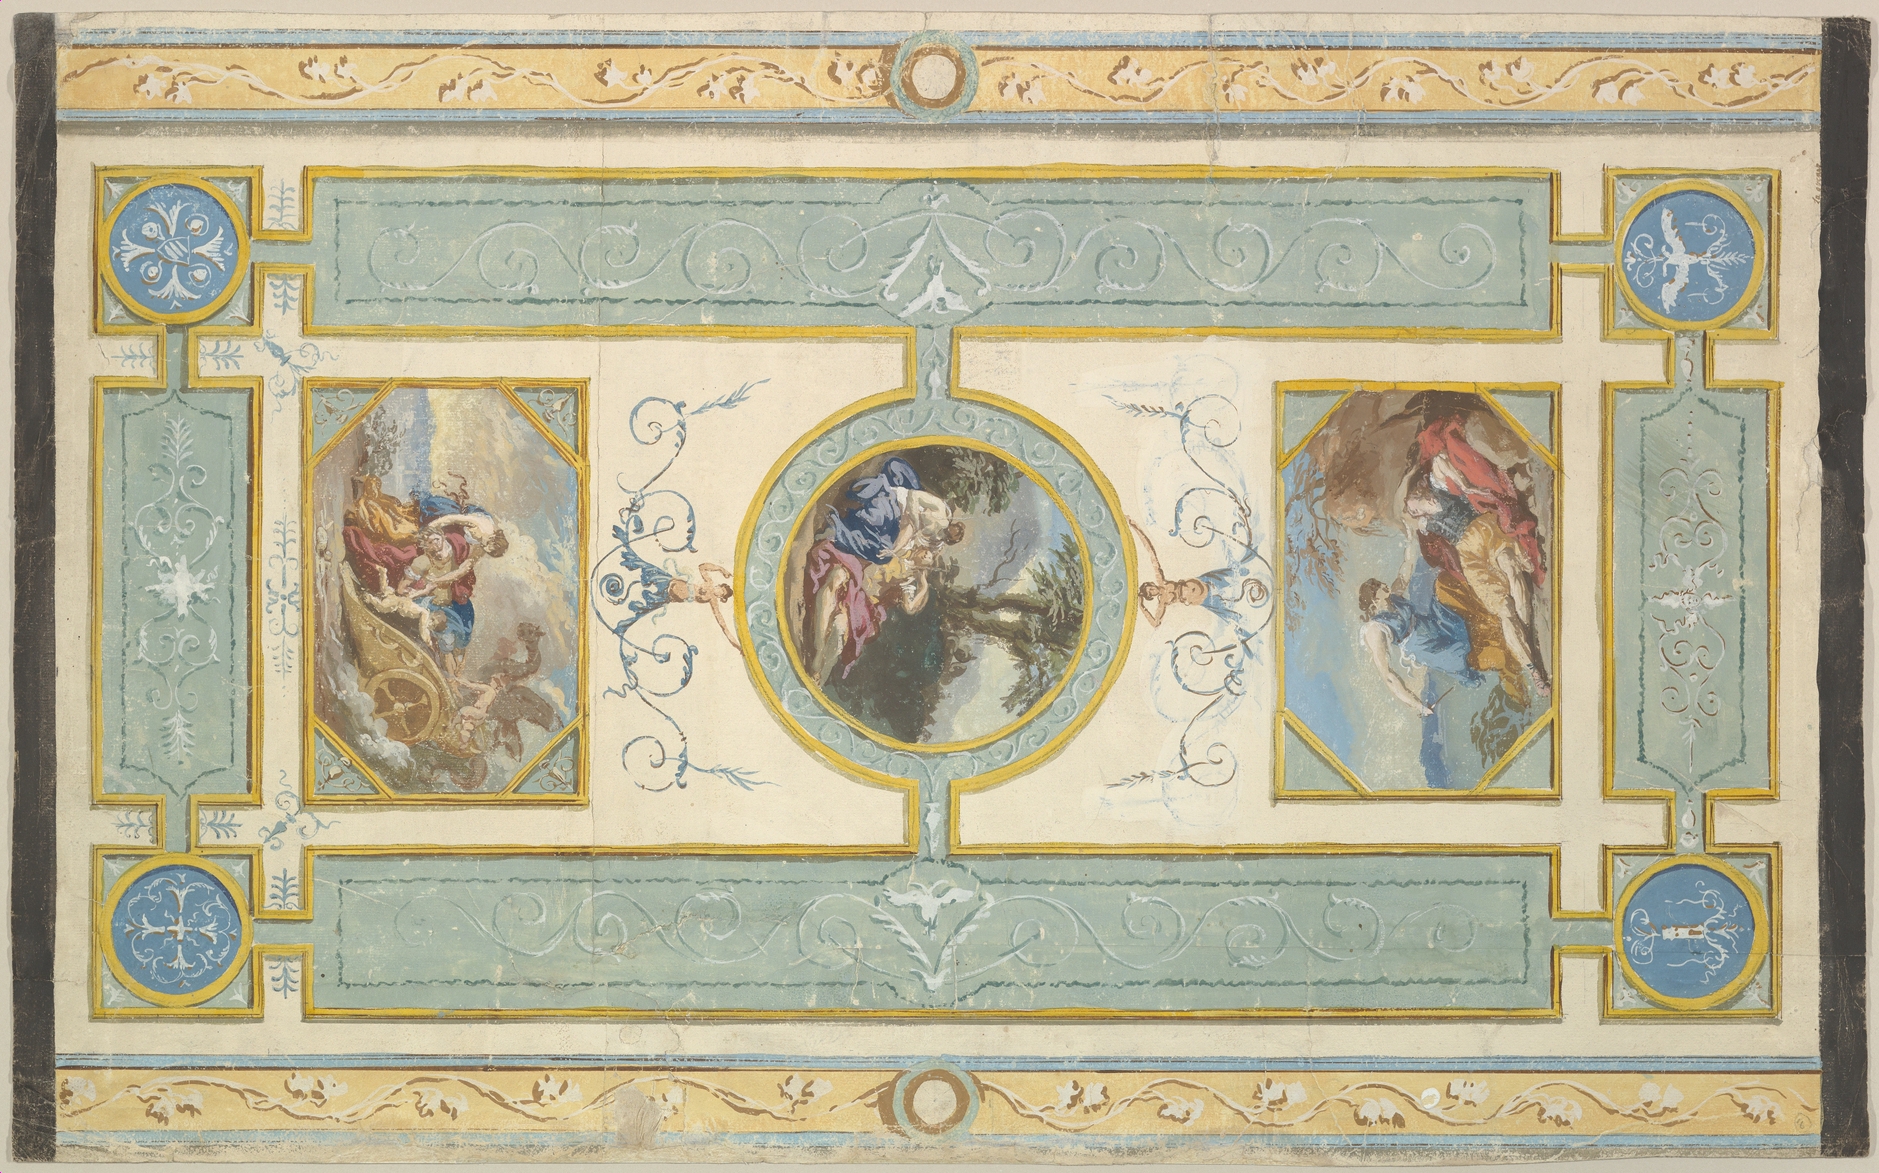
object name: drawing ornament architecture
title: Study for a Ceiling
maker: jean jacques lagrenée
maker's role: artist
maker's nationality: french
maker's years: 1739-1821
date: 1780-1800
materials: gouache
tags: architecture,ceilings